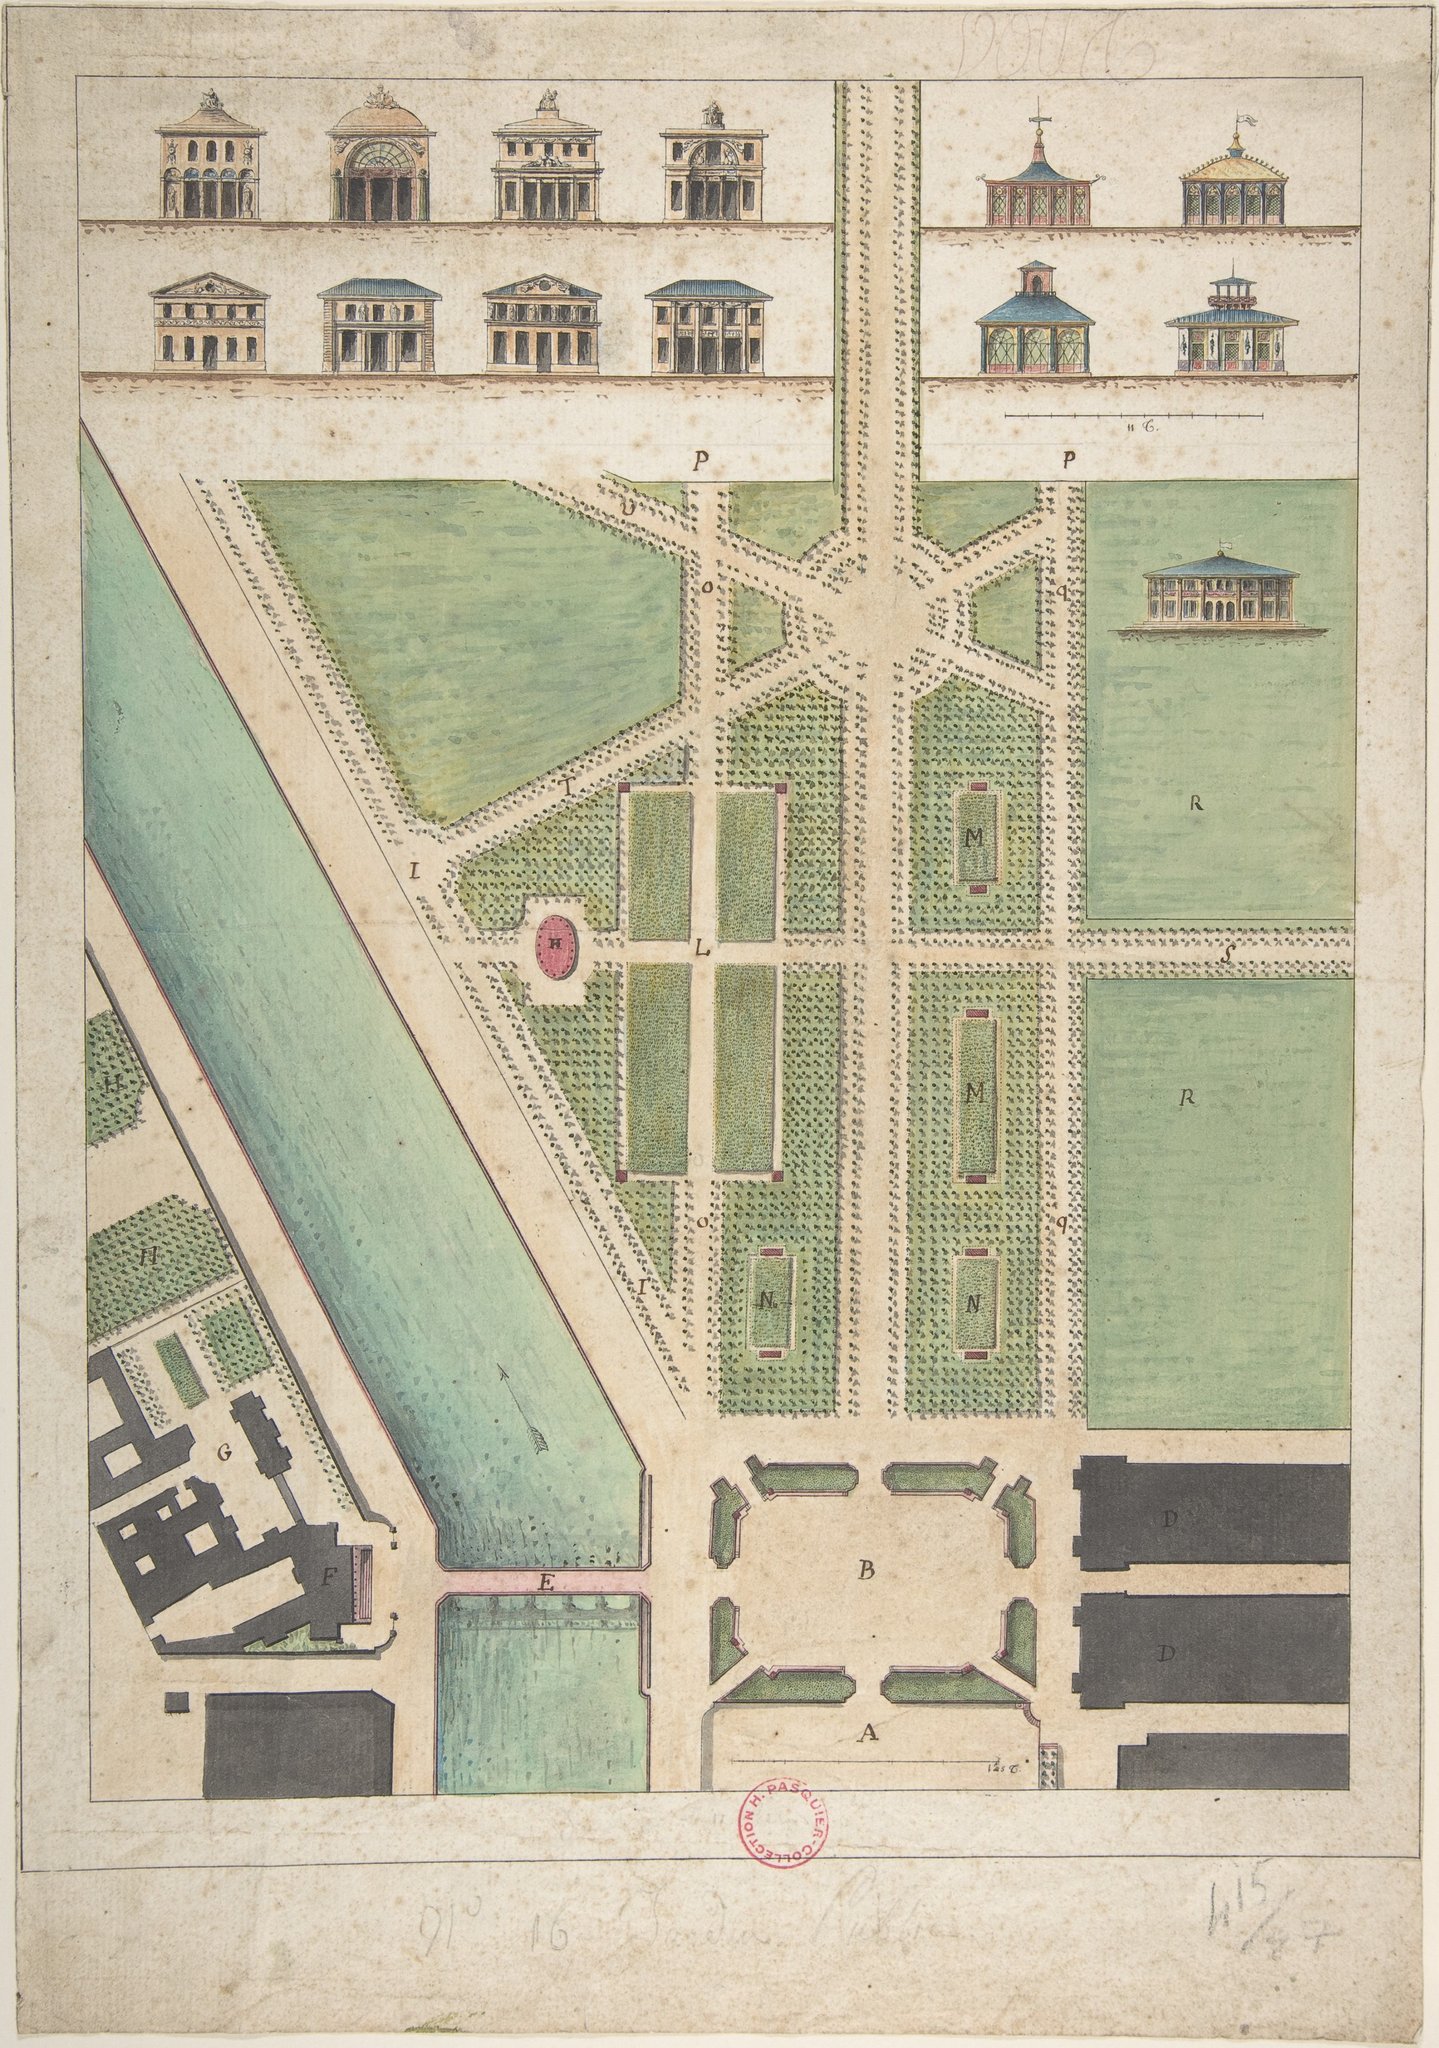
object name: print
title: Jardin Public, Champs Elysées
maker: gabriel thouin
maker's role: artist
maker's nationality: french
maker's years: 1747-1829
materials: ink, watercolor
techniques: brush, lithograph, pen, wash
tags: architecture,gardens